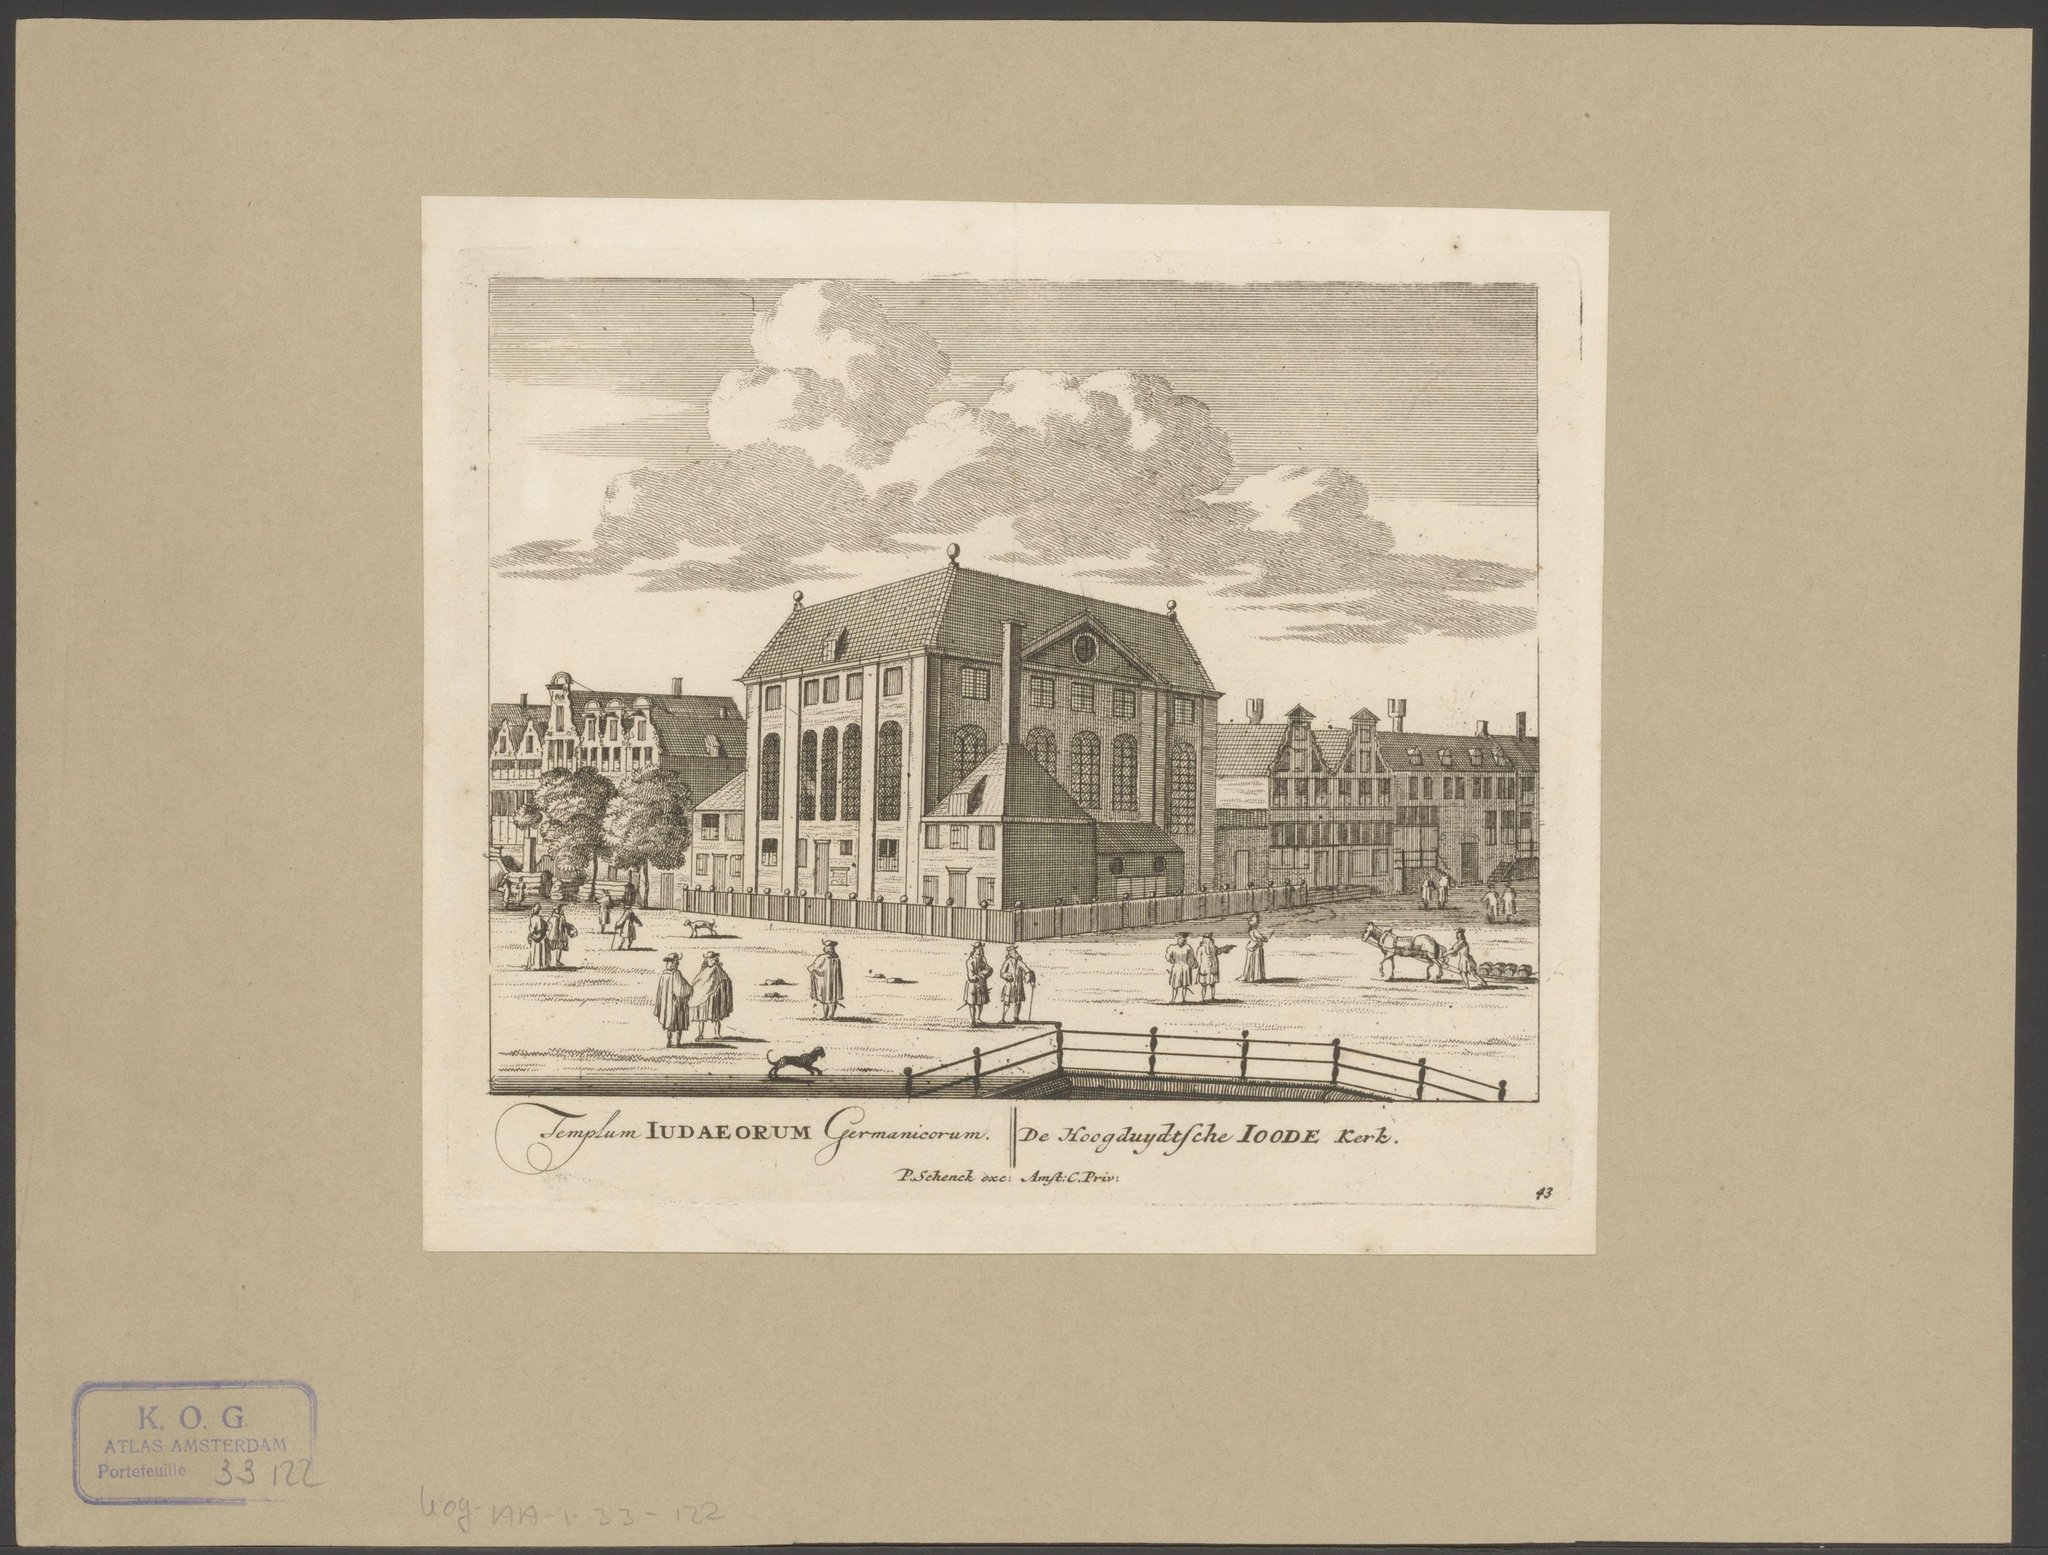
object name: print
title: Templum Iudaeorum Germanicorum / De Hoogduydtsche Ioode Kerk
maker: Anonymous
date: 1710-1711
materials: paper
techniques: engraving, etching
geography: northern netherlands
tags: the synagogue (as building and place of worship ~ jewish religion), street (+ city(-scape) with figures, staffage)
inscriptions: collector's mark: Lugt 1641b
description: Prent mogelijk uit: 100 Afbeeldinge der voornaamste gebouwen van Amsterdam. Amsterdam: Pieter Schenk (I), s.a. [1710-1711]. Of uit: 100 Afbeeldinge der voornaamste gebouwen van Amsterdam. Amsterdam: Barent Greve, s.a. [1757-1766]. In de tweede uitgave, uitgegeven door Barent Greve, is alleen de titelprent aangepast. De overige prenten zijn onveranderd gebleven.